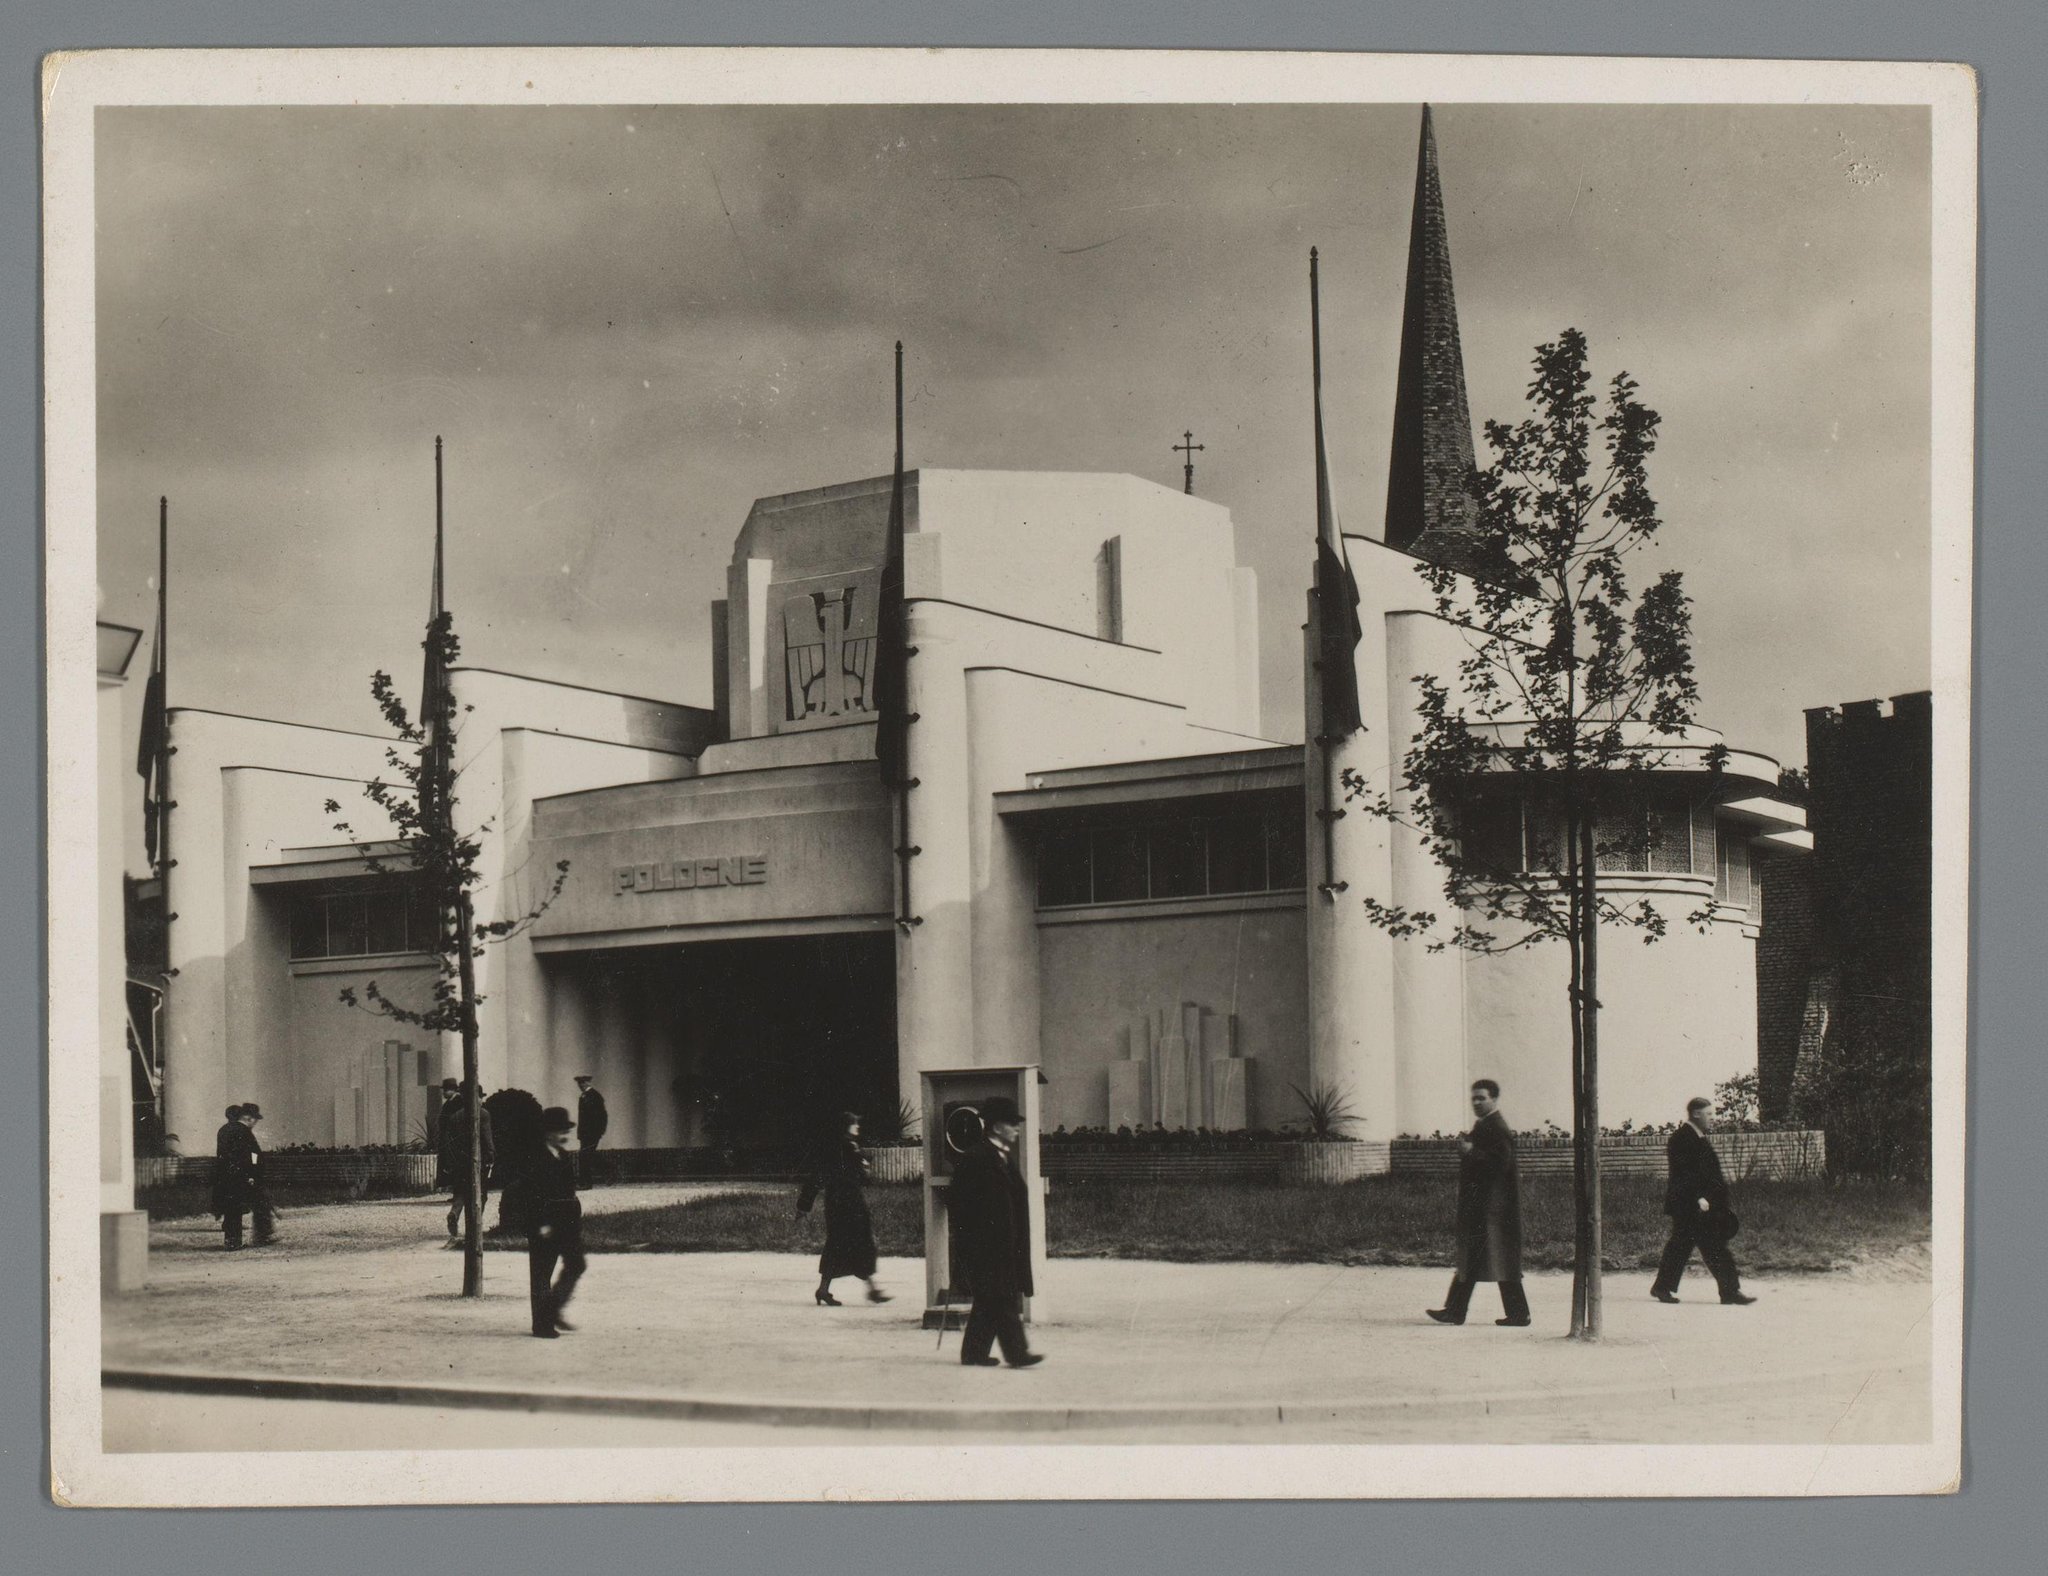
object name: photograph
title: Pools paviljoen op de Wereldtentoonstelling van 1935 in Brussel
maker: Anonymous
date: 1935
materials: paper, cardboard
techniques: gelatin silver print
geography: brussels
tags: world fair, world exhibition, brussels